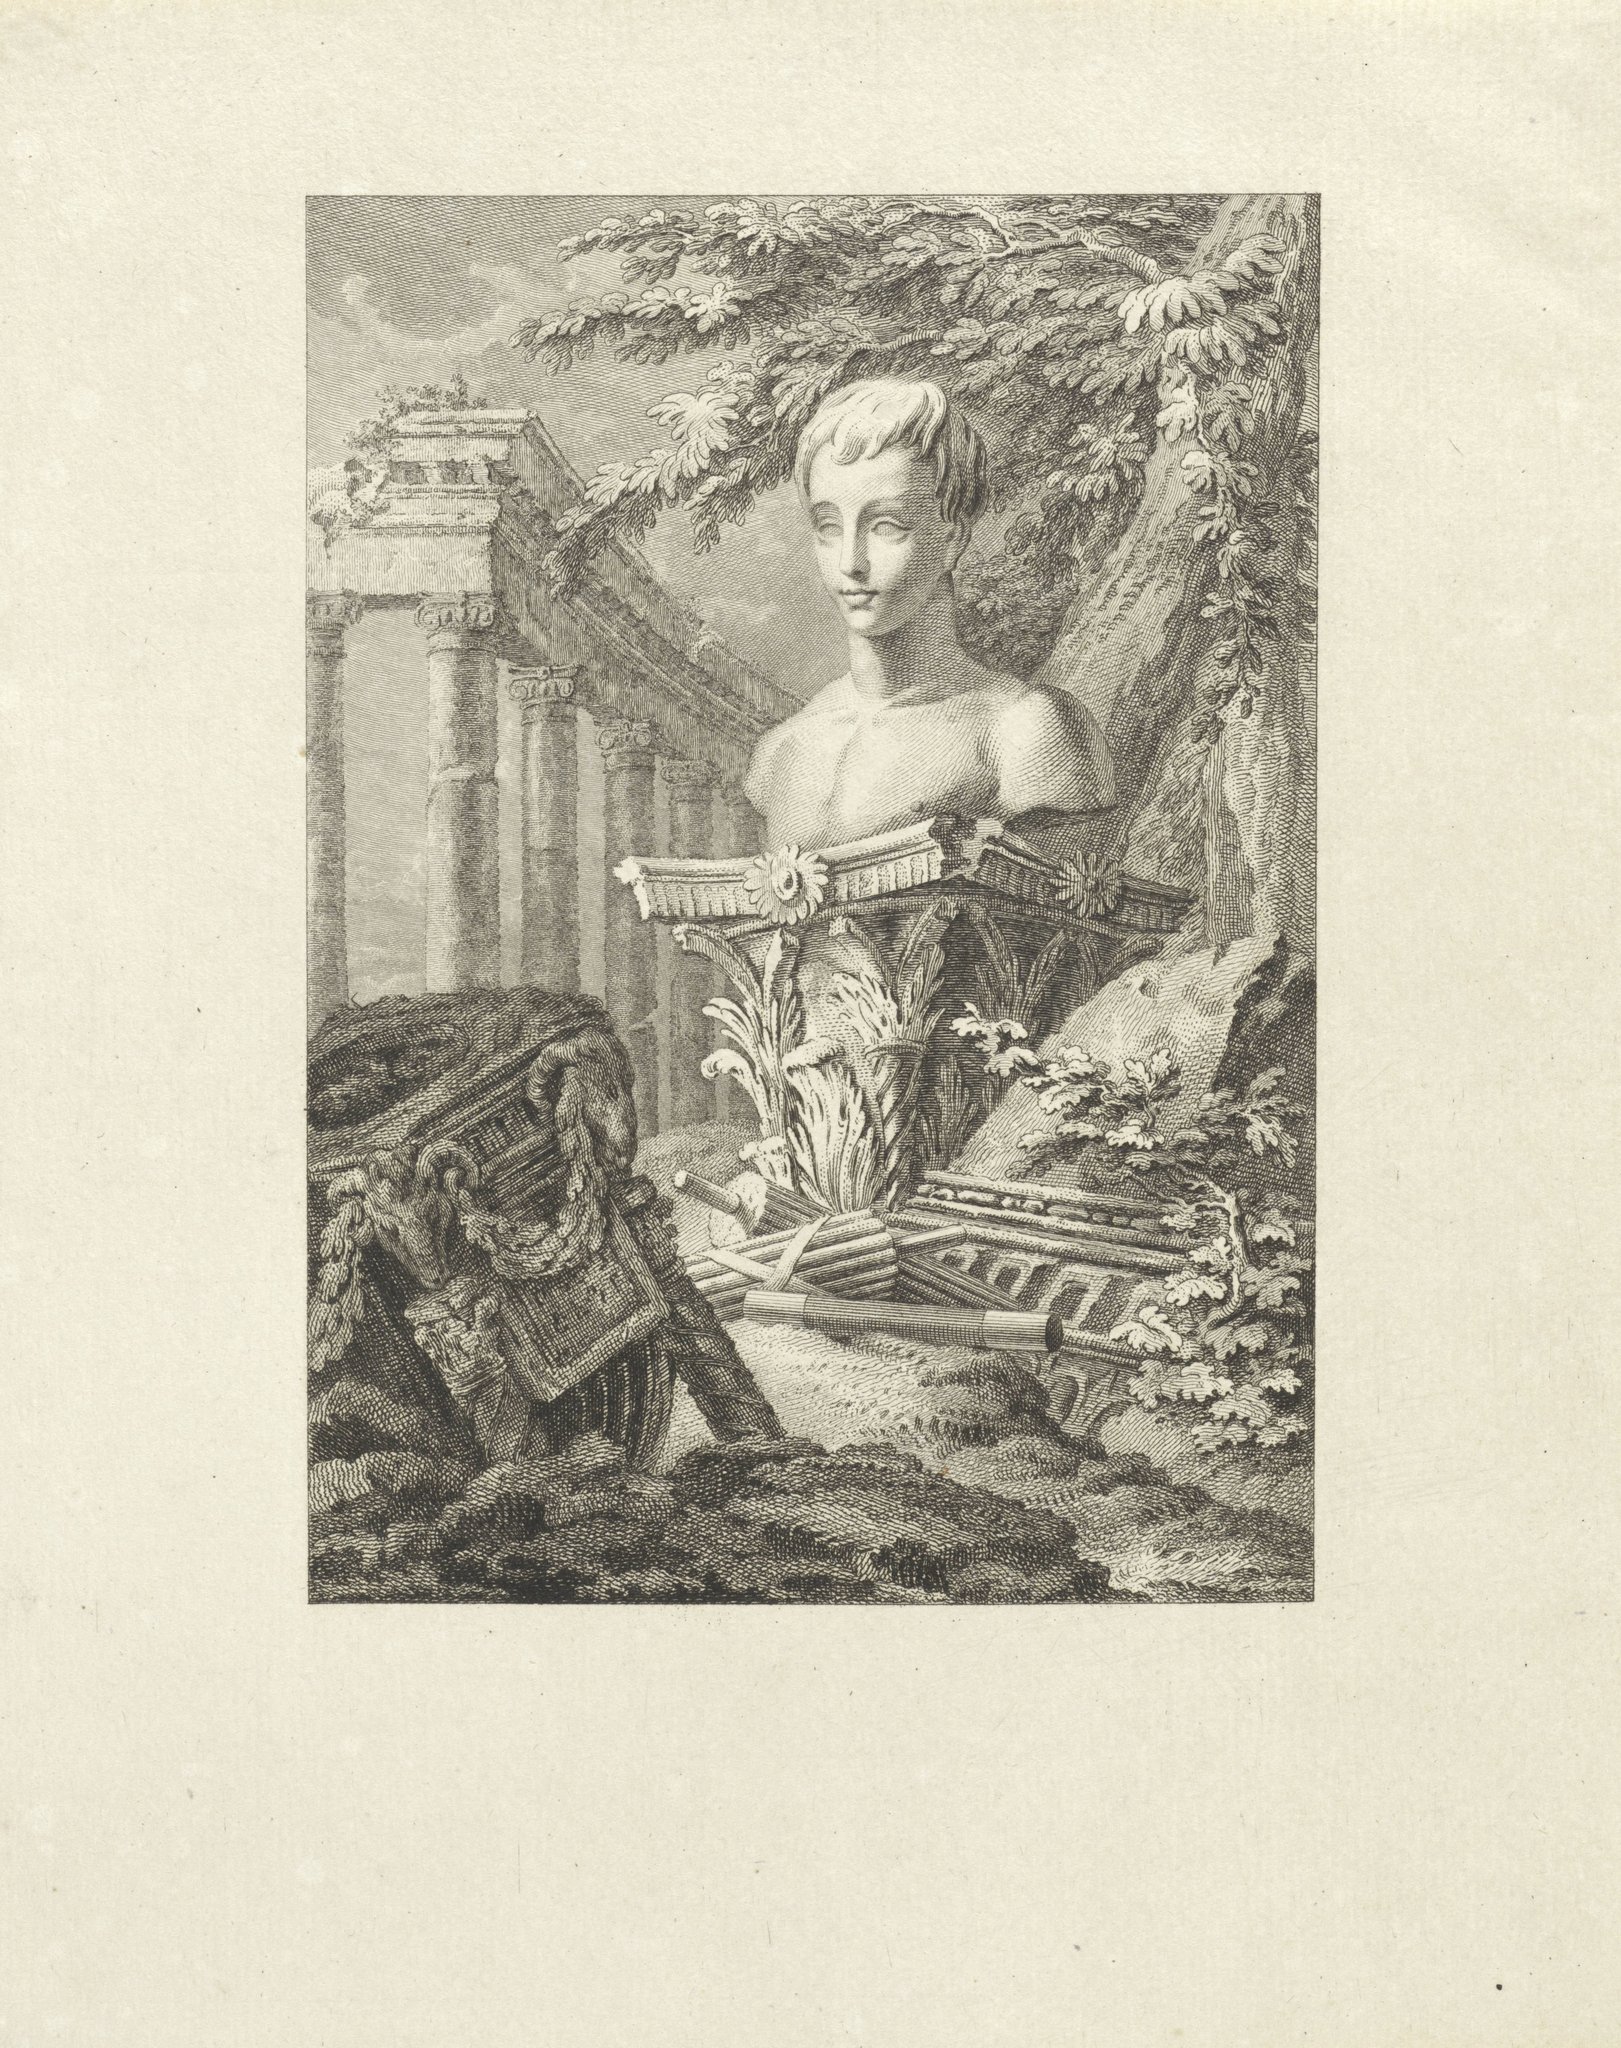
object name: print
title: Buste van Germanicus in een landschap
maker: reinier vinkeles (i)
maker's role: draughtsman, print maker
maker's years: 1741-1816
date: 1778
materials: paper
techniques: engraving, etching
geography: amsterdam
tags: symbols and allegories of law; 'legge', 'legge civile' (ripa) (+ 'fasces cum securibus'), colonnade, ruin of a building ~ architecture, capital (~ column, pillar), baton of general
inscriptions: collector's mark: Lugt 240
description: Buste van de Romeinse veldheer Germanicus, op een sokkel in een landschap met een klassieke ruïne met een zuilenrij. Op de grond liggen twee fasces en een commandostaf.